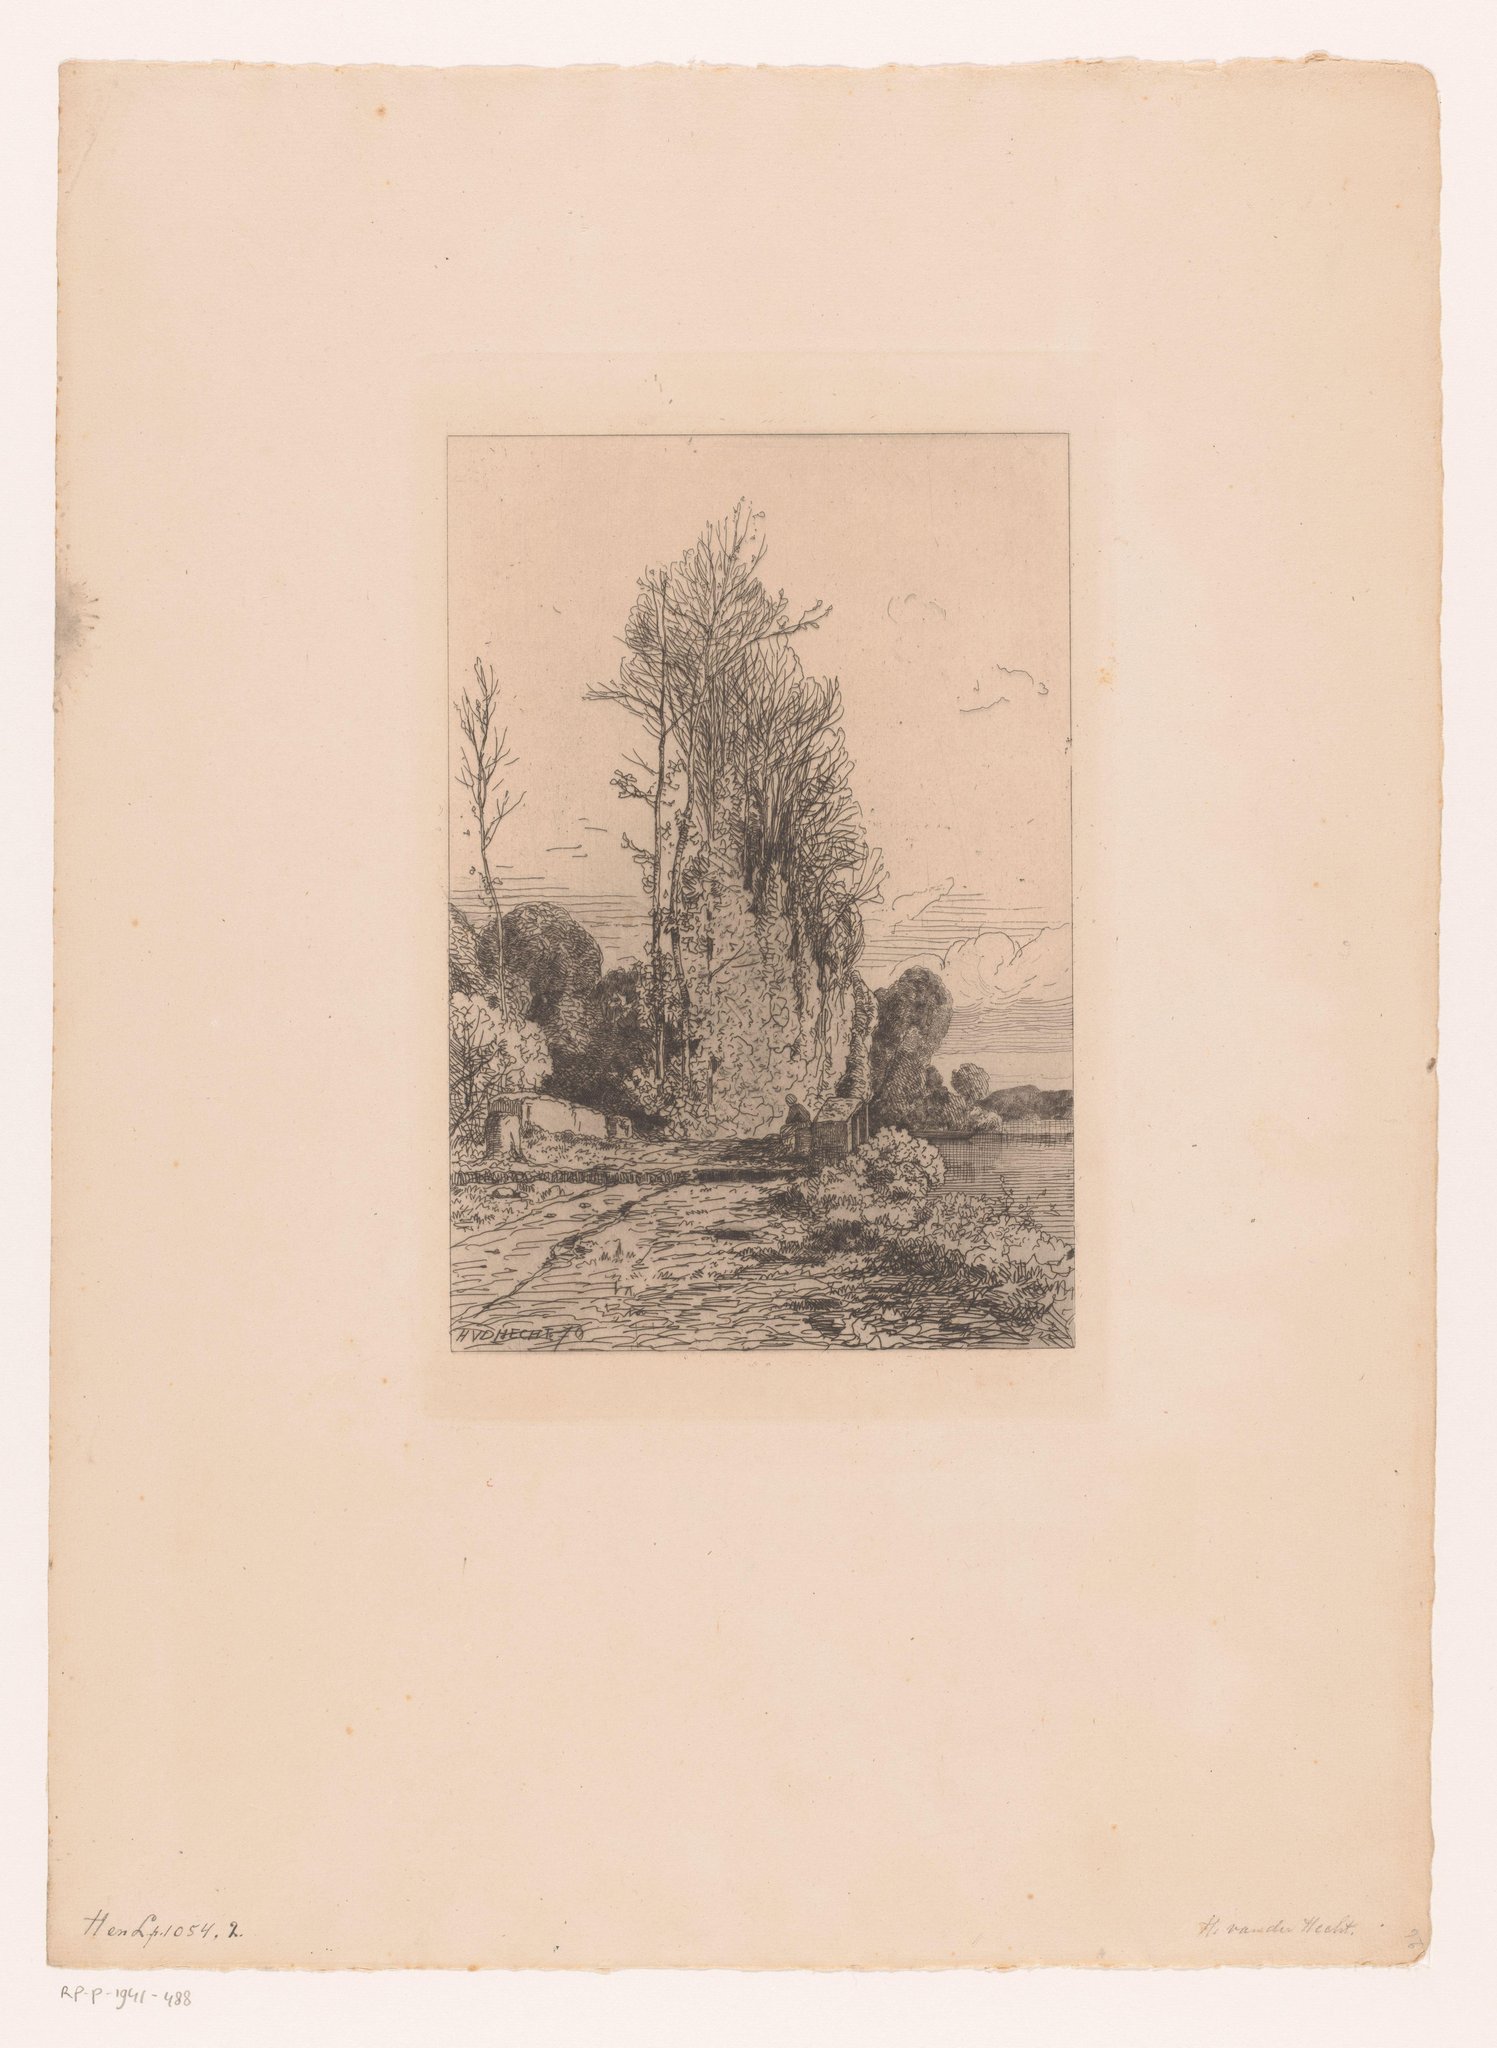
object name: print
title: Landschap met figuur op een brug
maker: hendrick van der hecht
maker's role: print maker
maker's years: 1841-1901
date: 1870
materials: paper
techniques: etching, intaglio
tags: sitting figure, landscape with bridge, viaduct or aqueduct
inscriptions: collector's mark: Lugt 2228, collector's mark: Lugt 2760